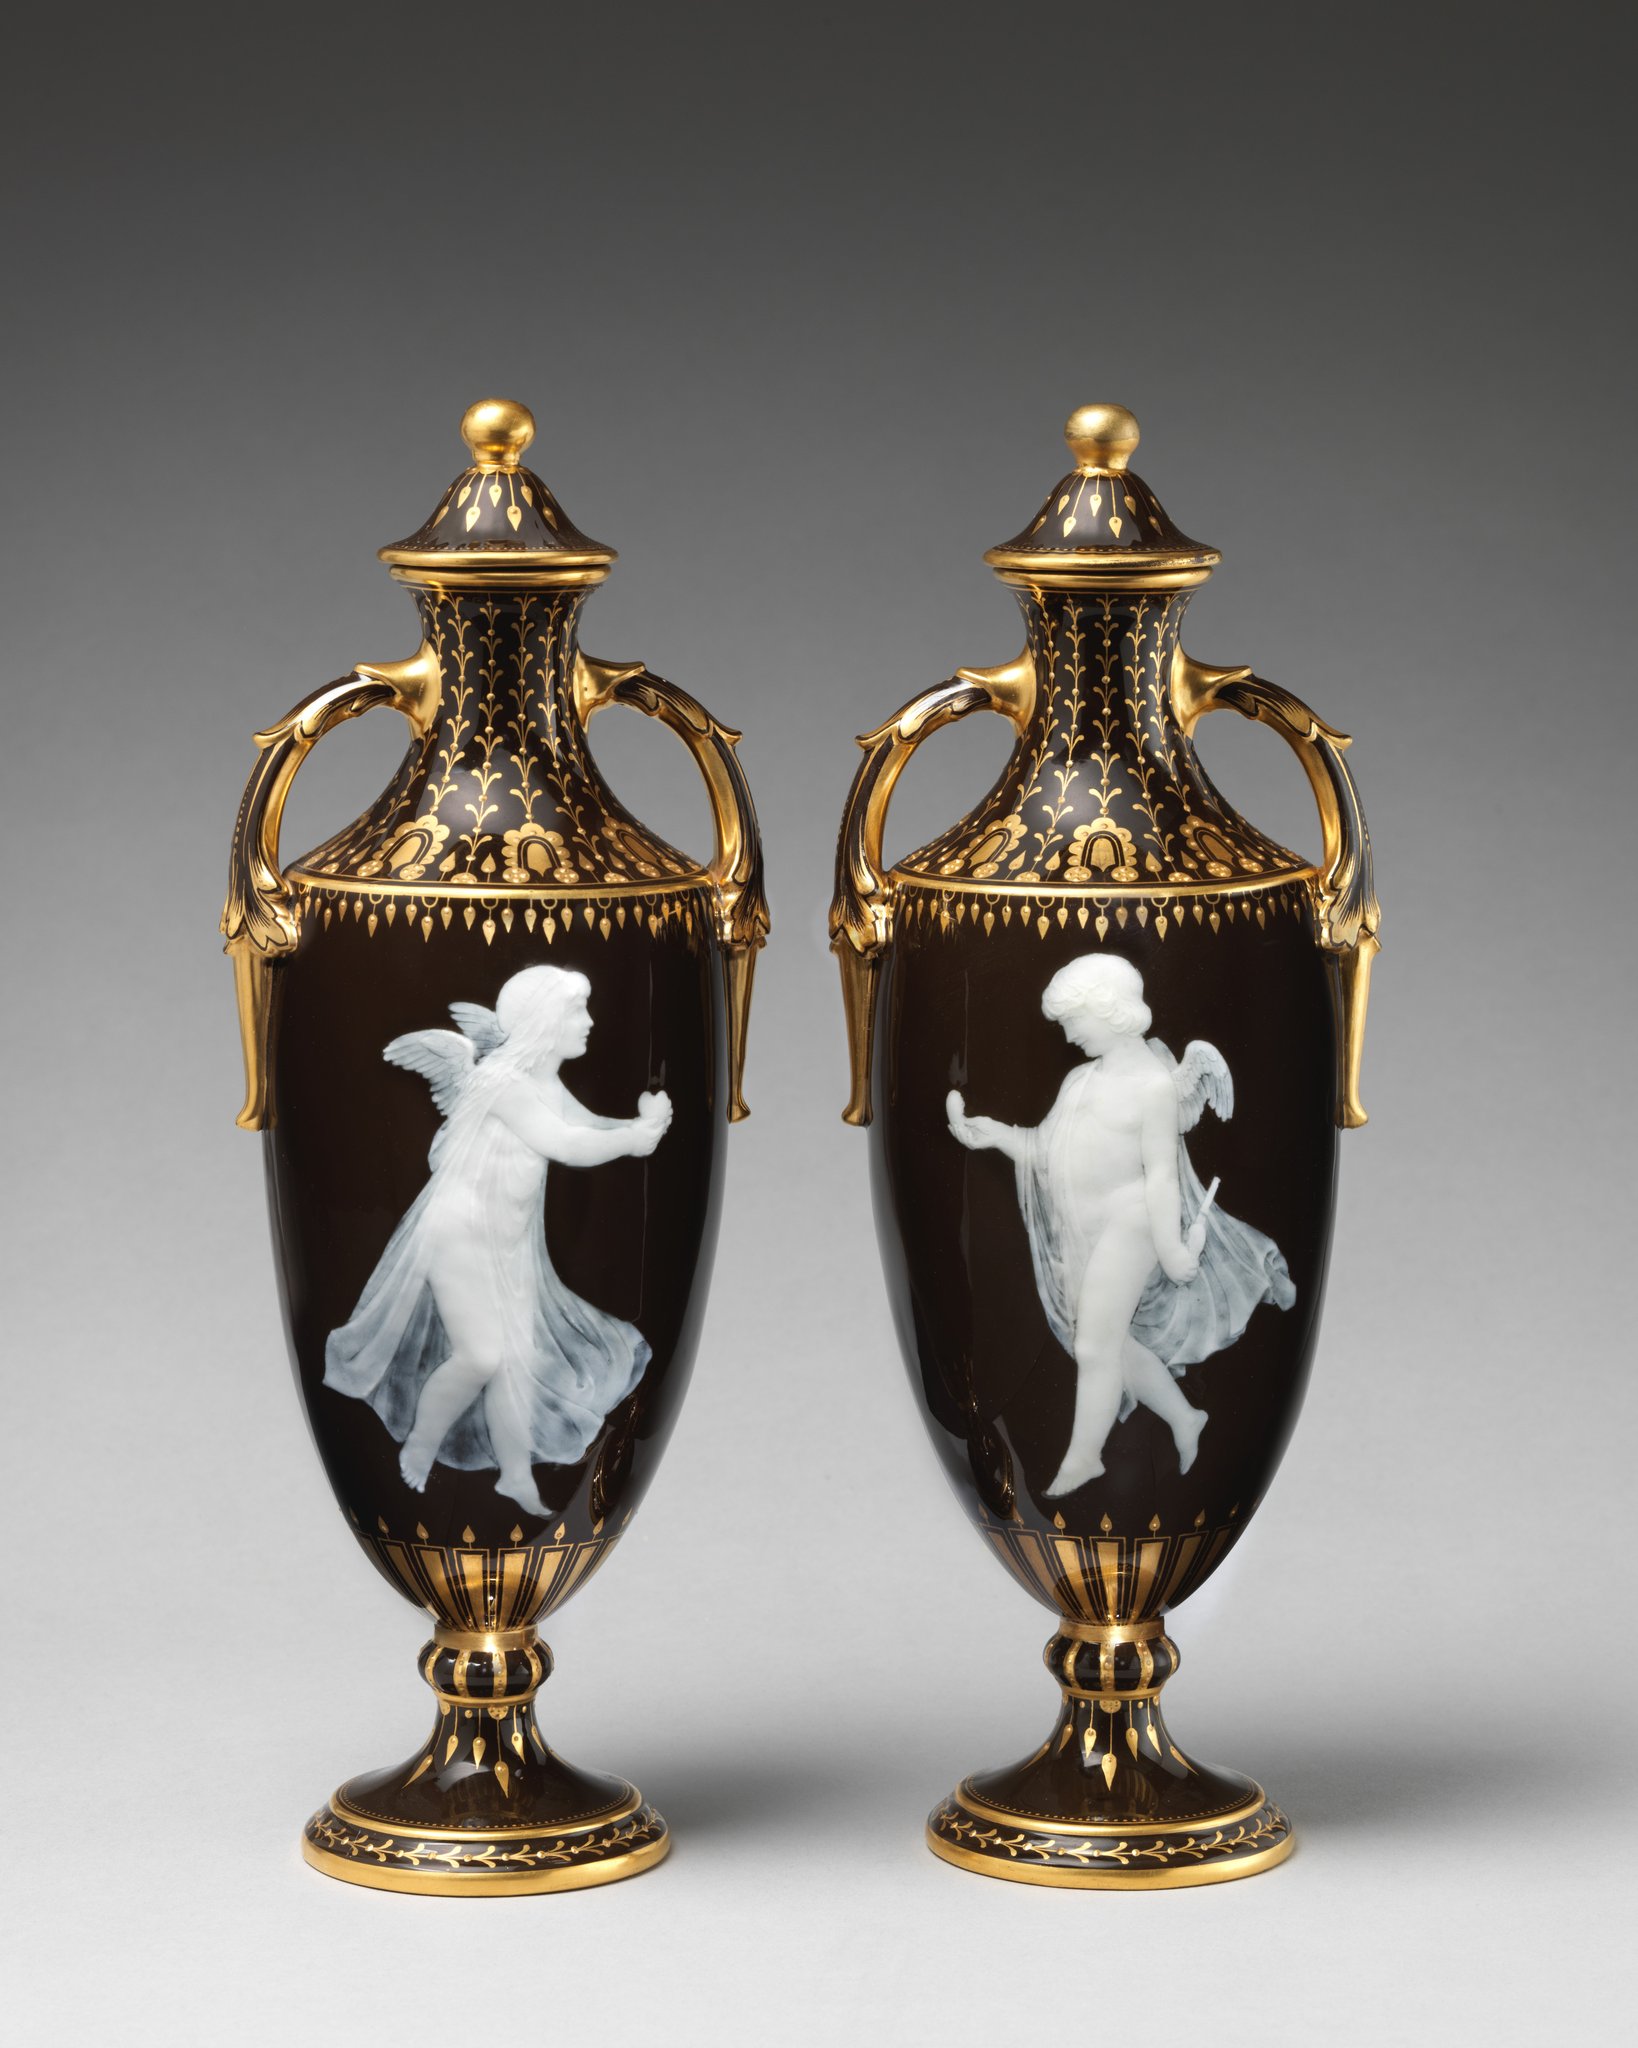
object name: vase pair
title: The Half and The Whole (pair of vases)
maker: minton(s)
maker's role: maker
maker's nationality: british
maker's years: 1793-2001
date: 1895-1899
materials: bone china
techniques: gilding